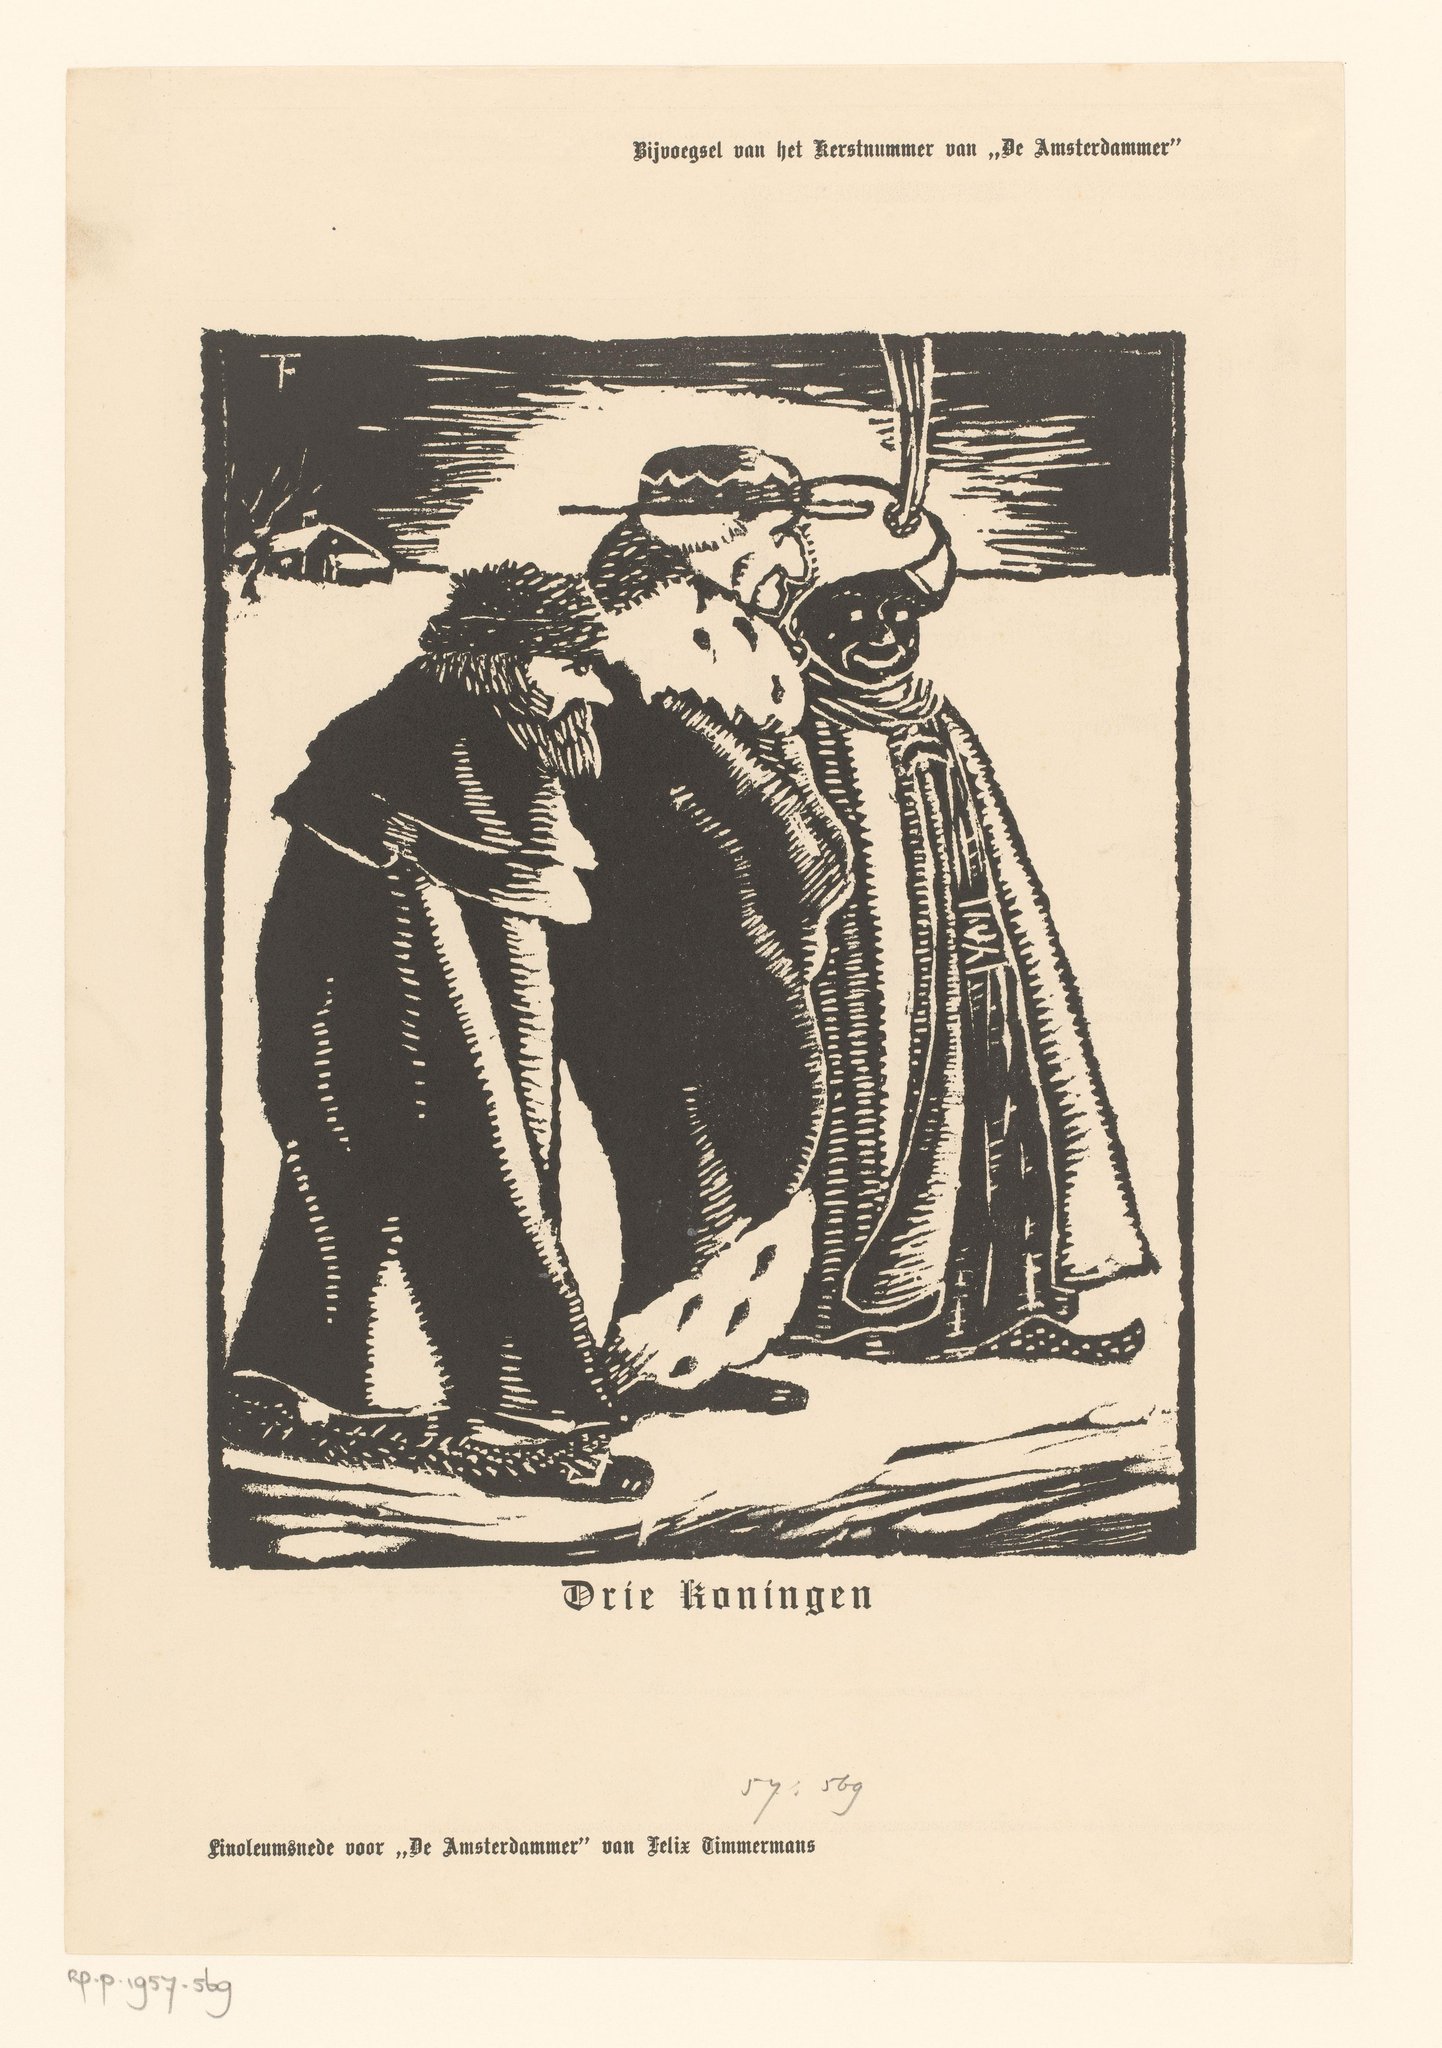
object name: print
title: Drie Koningen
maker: felix timmermans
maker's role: print maker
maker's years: 1886-1947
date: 1896-1947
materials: paper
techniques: linocut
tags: journey of the three wise men to jerusalem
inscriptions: collector's mark: Lugt 2228